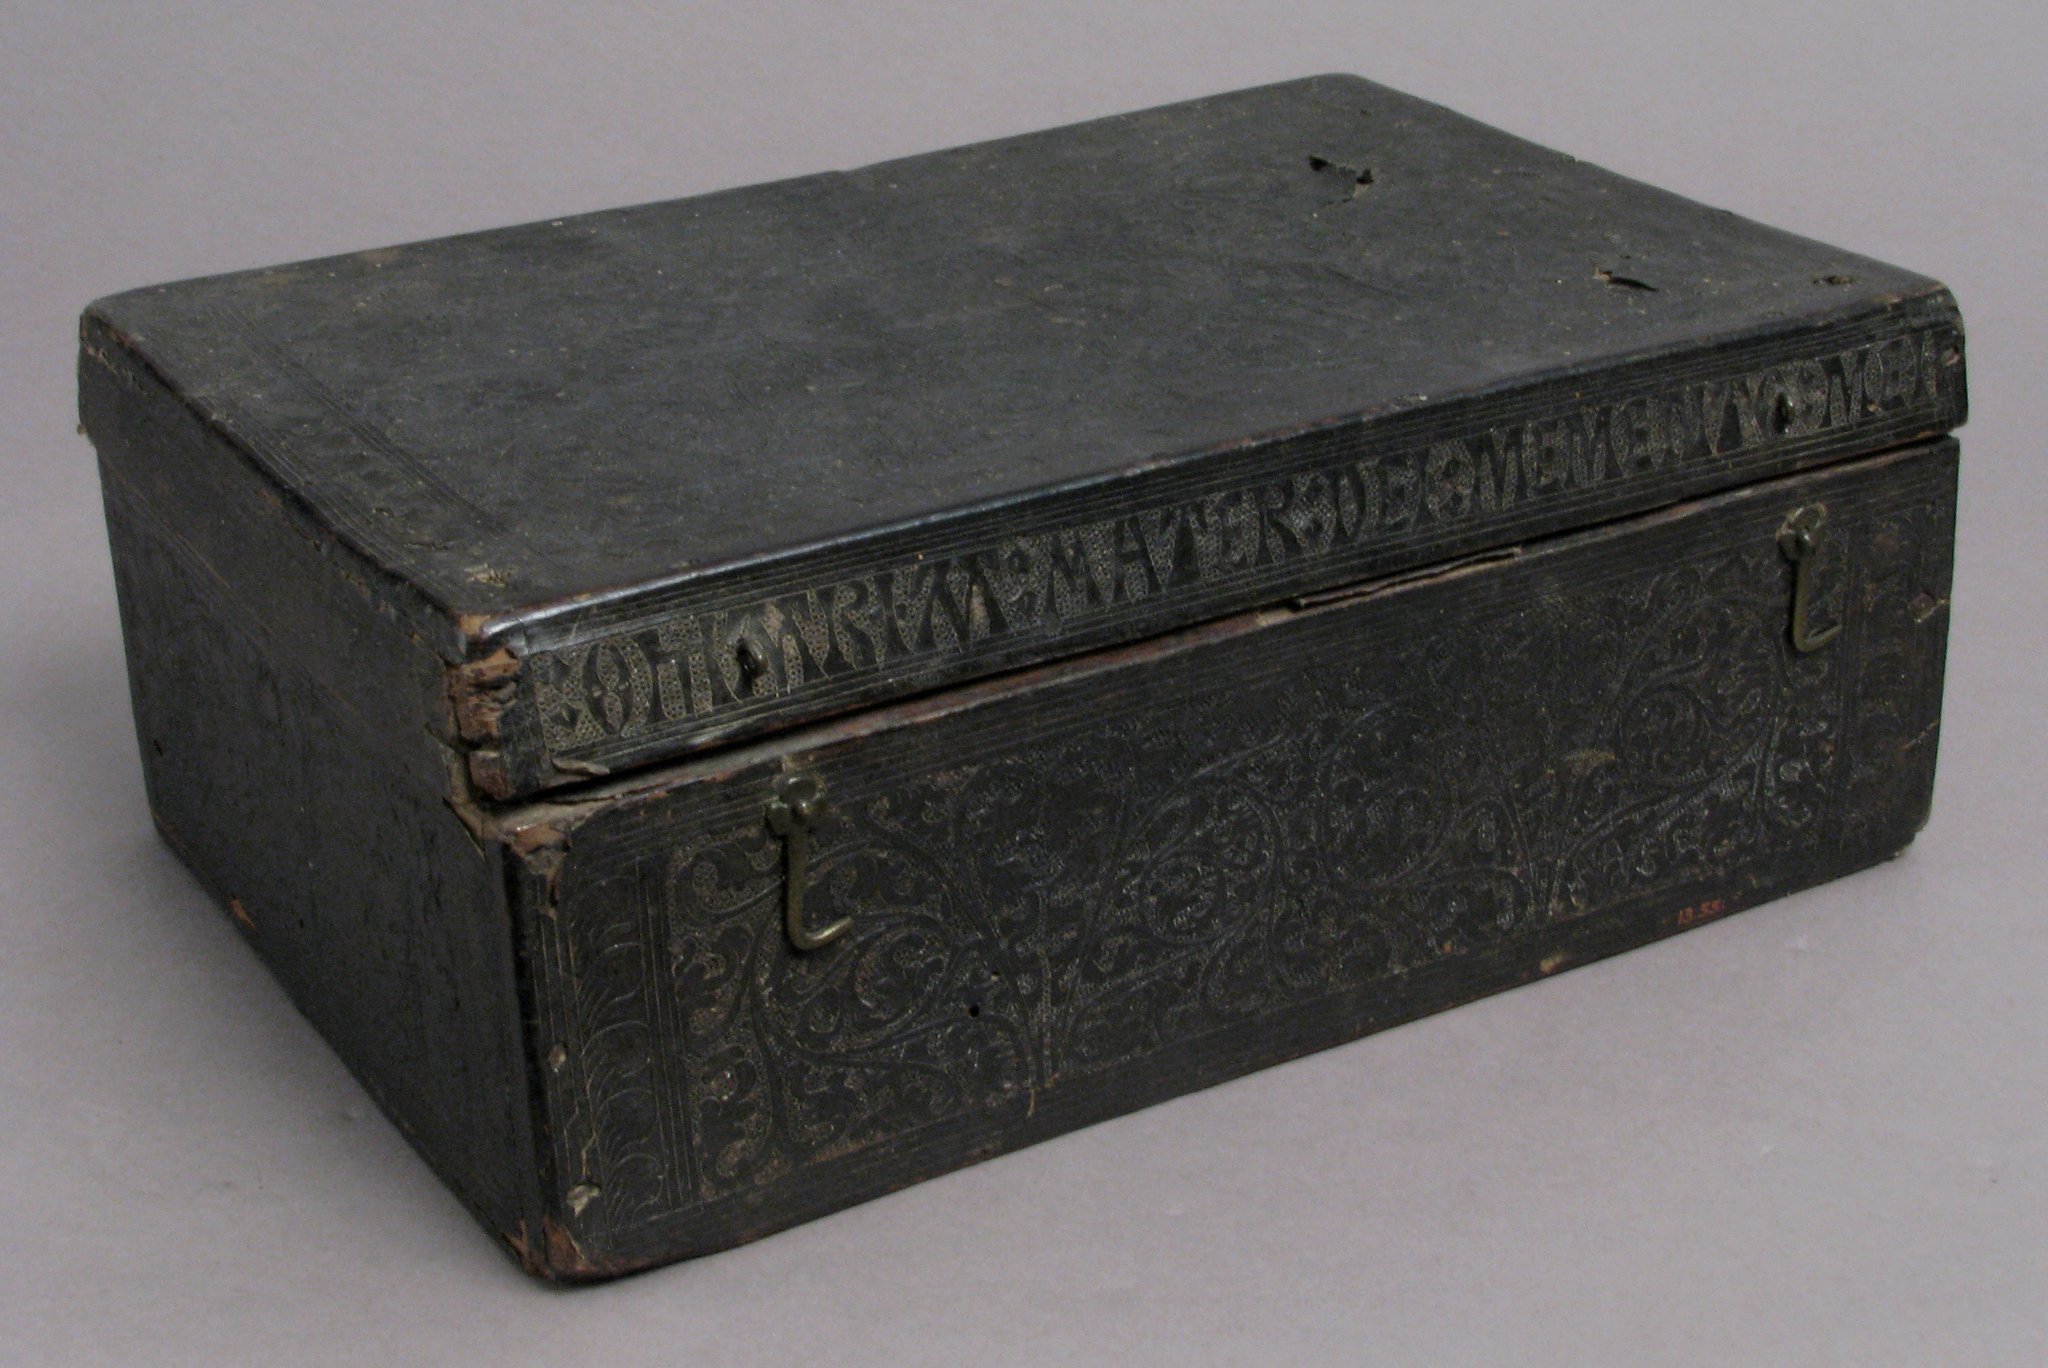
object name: box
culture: italian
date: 1467-1500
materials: leather, wood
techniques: tooling